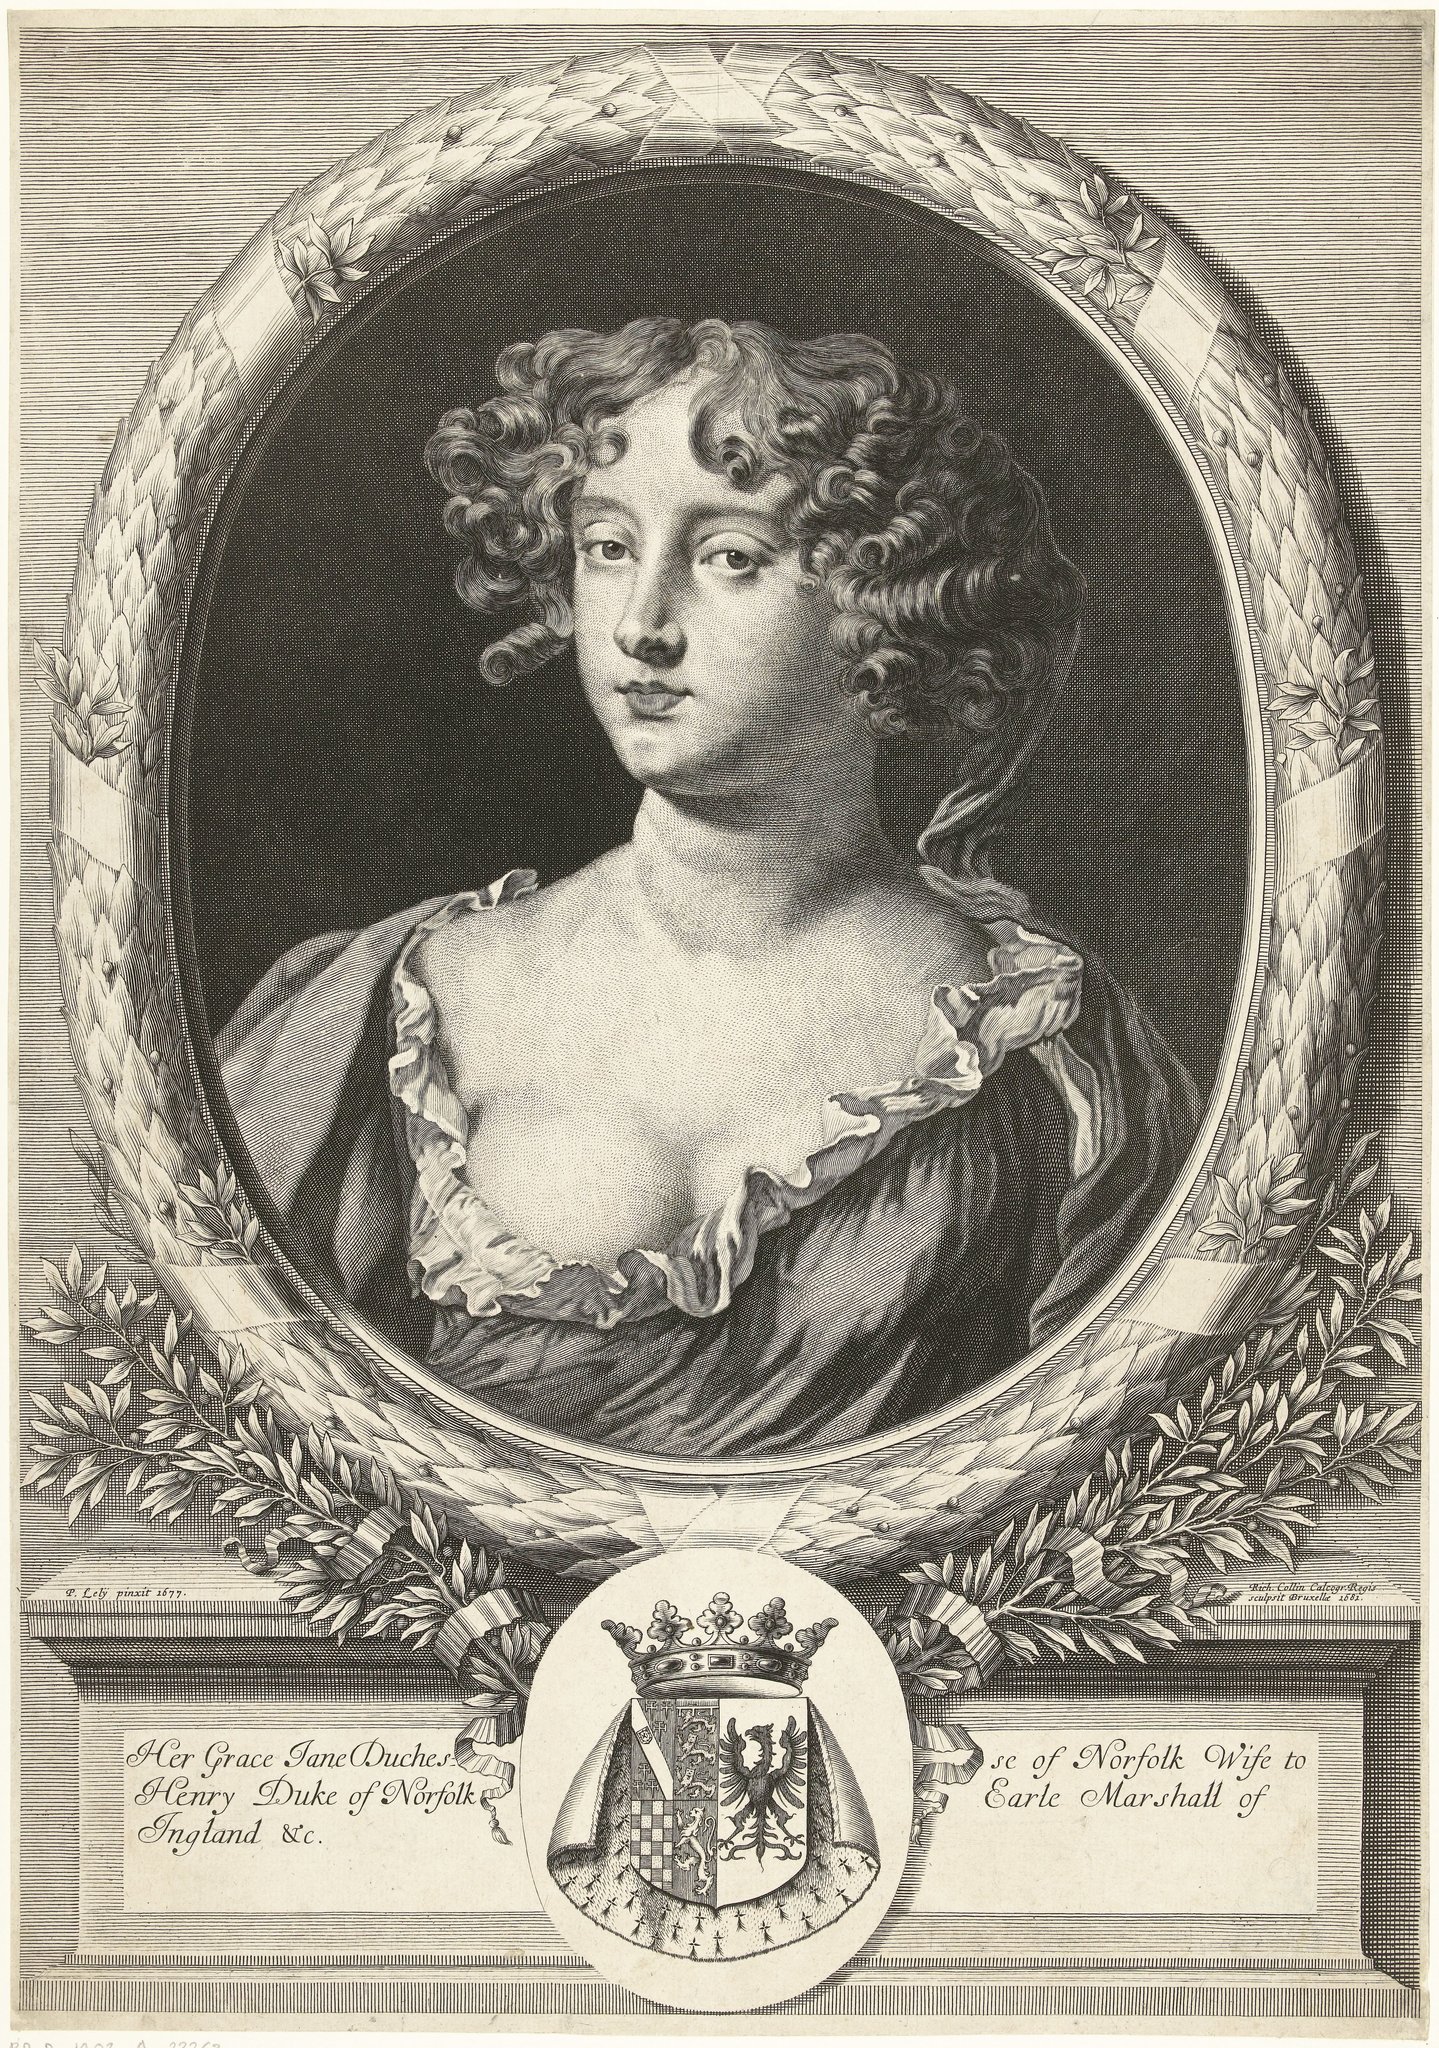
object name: print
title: Portret van Jane Bickerton hertogin van Norfolk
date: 1681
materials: paper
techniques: engraving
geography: england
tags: jane bickerton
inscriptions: collector's mark: Lugt 2228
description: Borstbeeld van de tweede vrouw van de hertog van Norfolk Henry Howard. In een ovale omlijsting van laurierbladen. Onder het portret haar naam, familiewapen en titels.